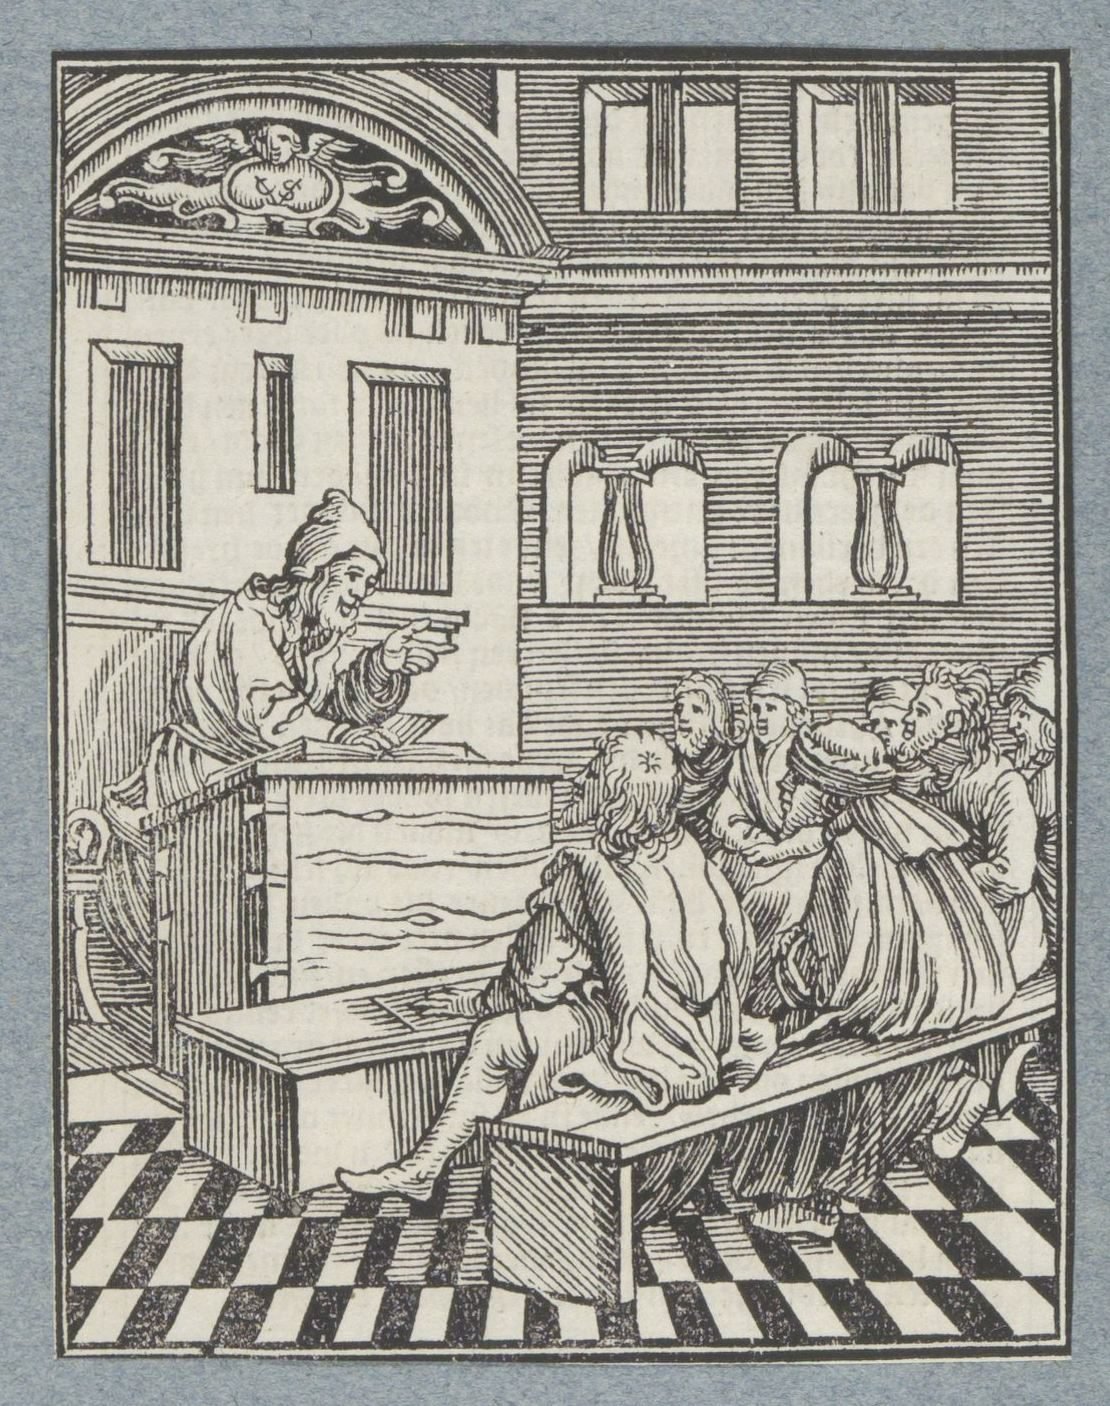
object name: print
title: Profeet Amos onderwijst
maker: pieter jacobsz. paets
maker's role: publisher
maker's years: 1587-1667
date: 1645-1646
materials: paper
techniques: letterpress printing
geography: amsterdam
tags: amos, the herdsman of tekoa, prophesies at bethel (amos 1-2)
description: De prent werd gemaakt voor de uitgaven van P.J. Paets uit Amsterdam. Ze komt in ieder geval voor in: Bibels Tresoor ofte der zielen lusthof. Amsterdam, P.J. Paets, 1646. Mogelijk ook in: Historien ende Prophetien. [Amsterdam], P.J. Paets, 1645.